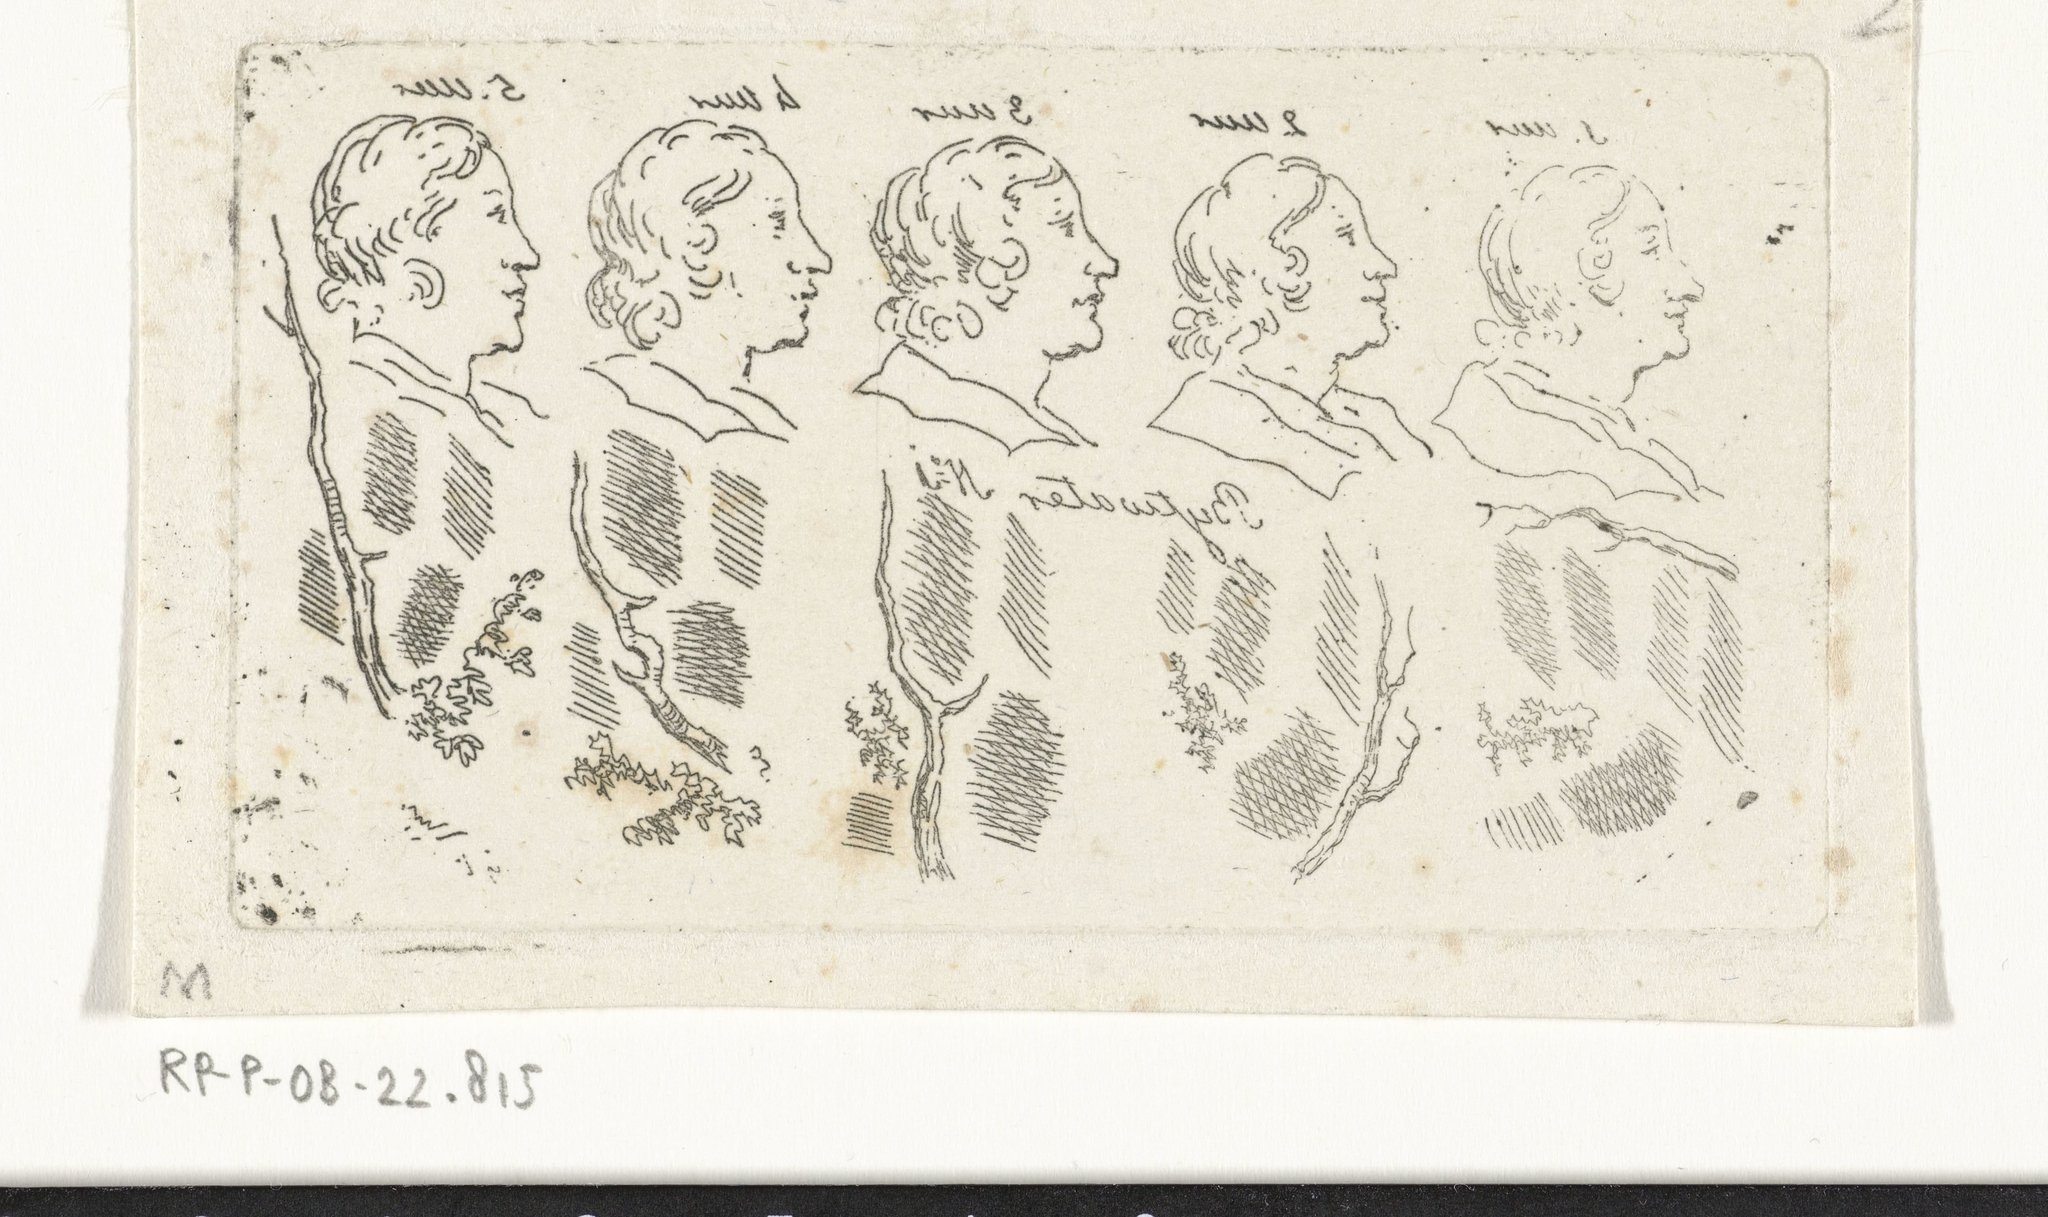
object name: print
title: Studieblad met koppen, takken en arceringen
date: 1803-1842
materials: paper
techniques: etching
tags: head (human) (+ right side visible; right - (r. hand, r. foot, etc.))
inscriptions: collector's mark: Lugt 2228, inscription: ‘Bytwater no.1’, inscription: ‘5 uur, 4 uur, 3 uur, 2 uur, 1 uur’